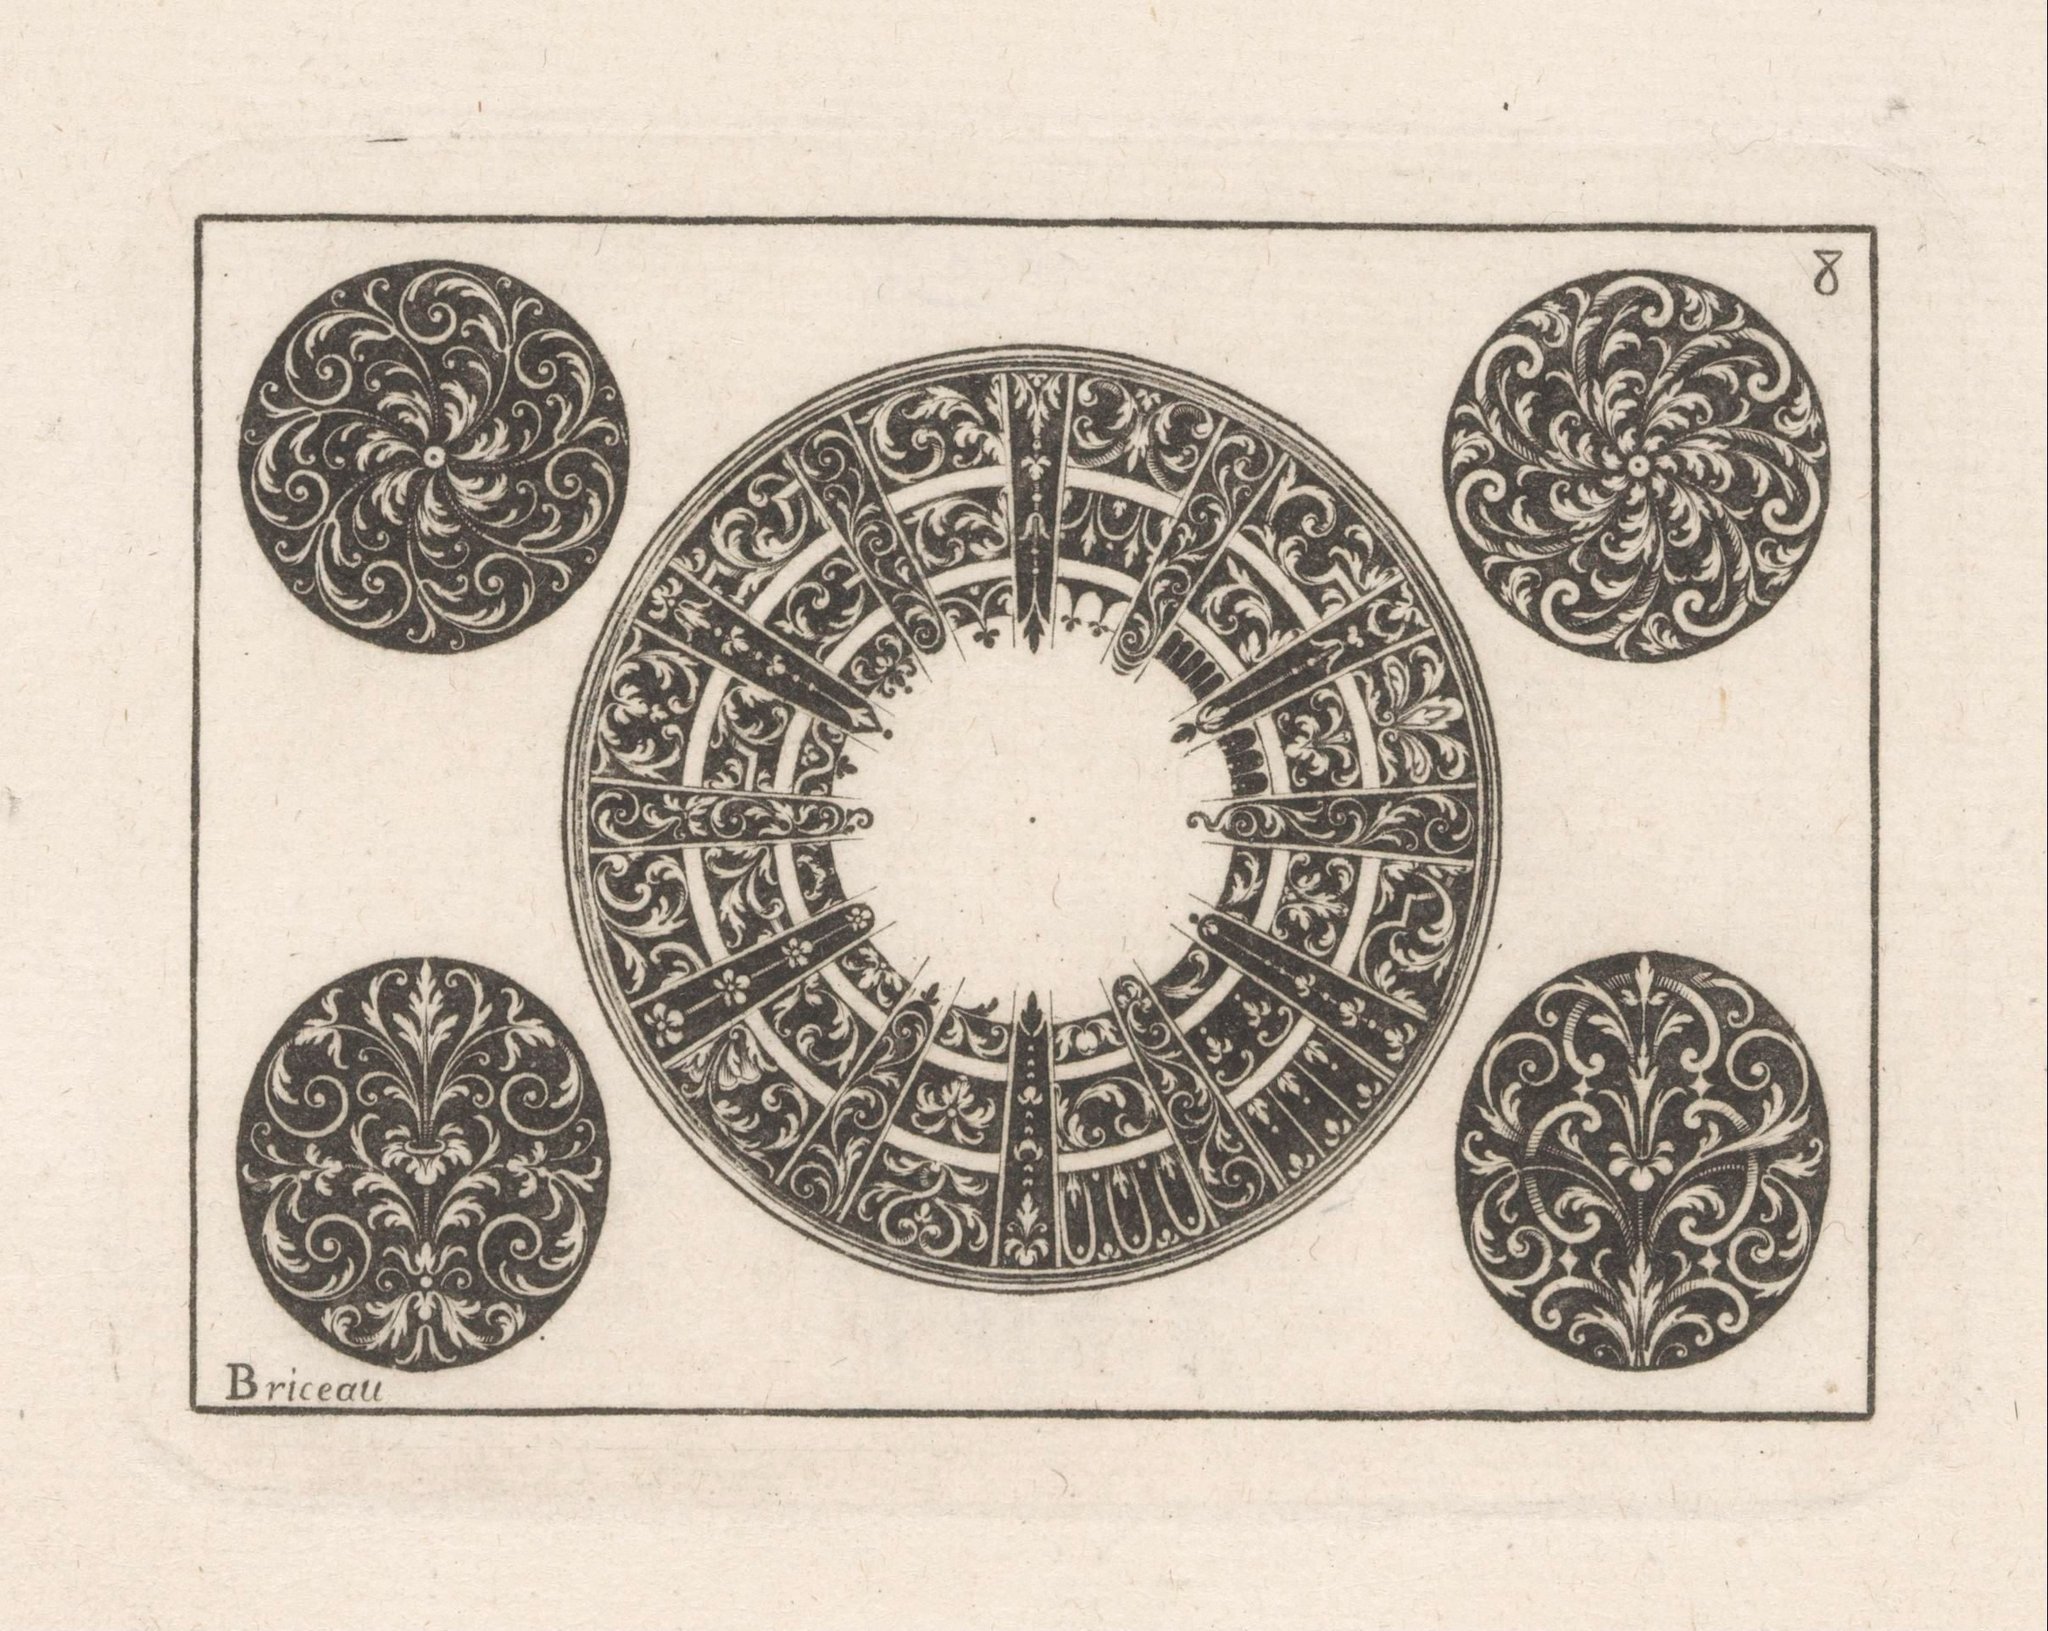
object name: ornament print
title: Vijf medaillons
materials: paper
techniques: etching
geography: paris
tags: interlace ~ ornament, ornament ~ medallion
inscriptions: collector's mark: Lugt 2166, collector's mark: Lugt 2228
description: Een geornamenteerd medaillon omringd door vier kleine medaillons gevuld met vlechtwerk.